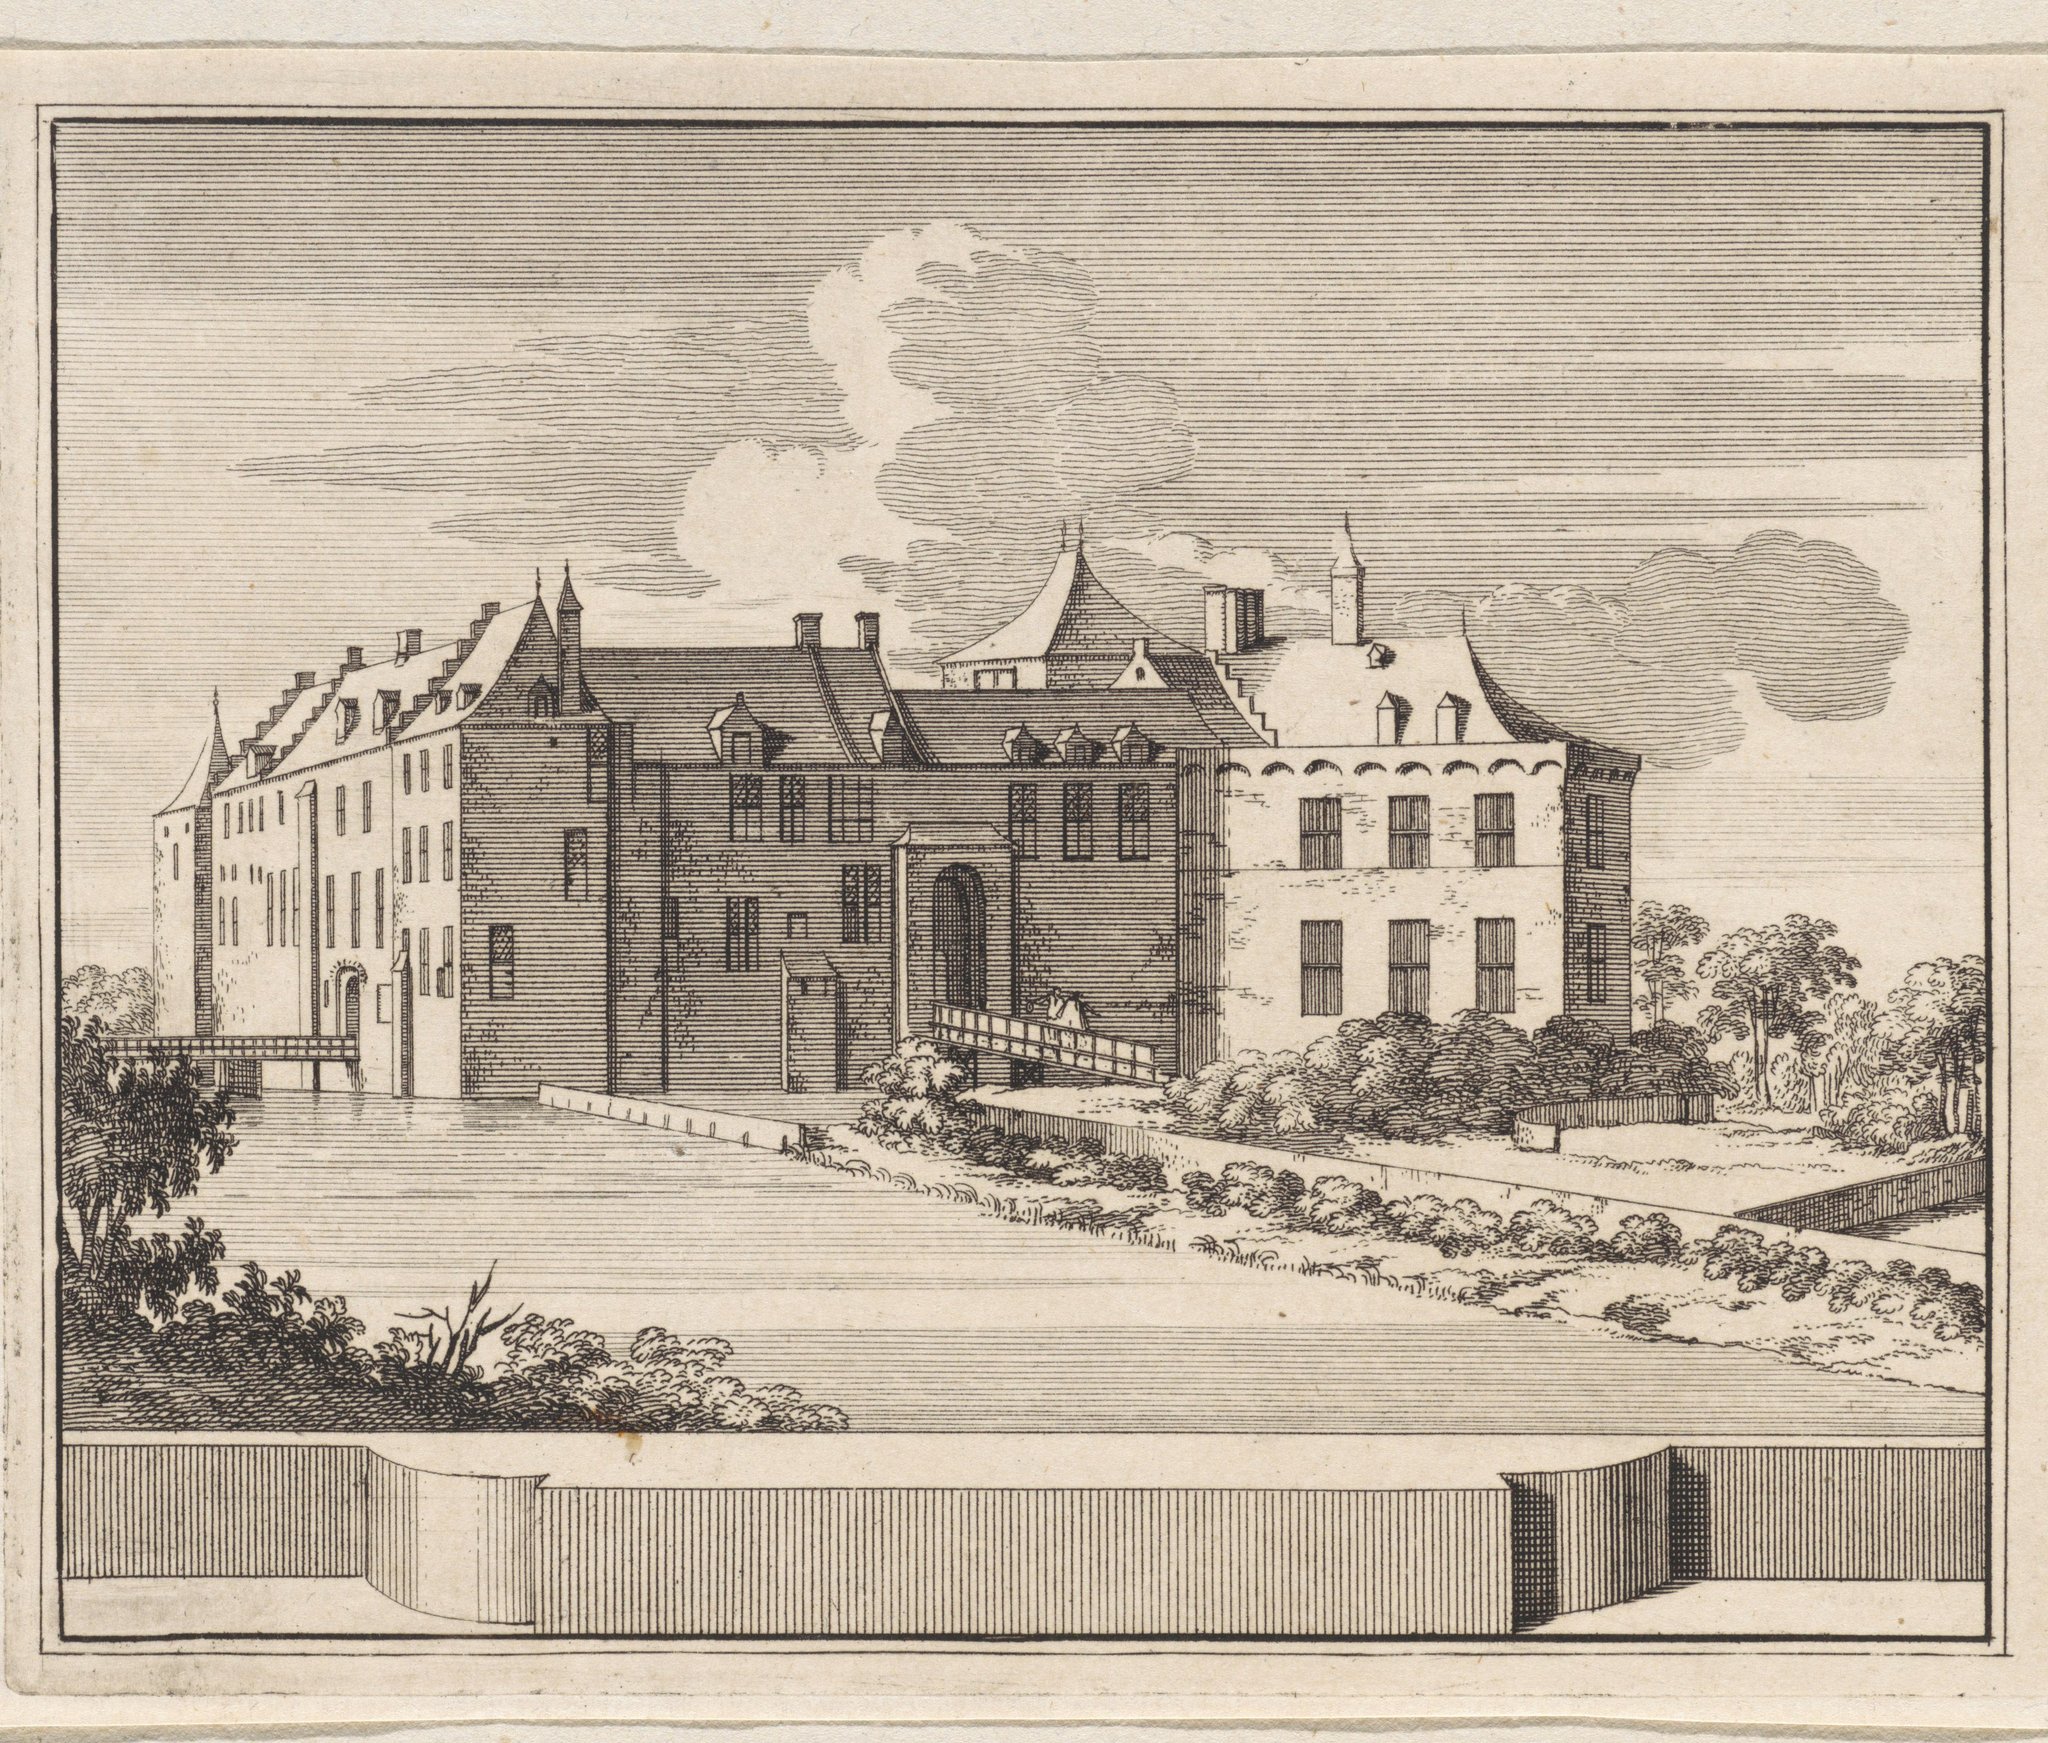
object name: print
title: Gezicht op kasteel IJsselstein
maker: jacobus schijnvoet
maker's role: draughtsman, print maker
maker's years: 1685-1743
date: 1711-1774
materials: paper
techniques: etching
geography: amsterdam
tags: castle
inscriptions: collector's mark: Lugt 2228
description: Latere staat van deze prent als illustratie opgenomen in: Smids, Ludolph. Schatkamer der Nederlandsse[!] oudheden; of Woordenboek, behelsende Nederlands steden, Amsterdam: Pieter de Coup, 1711. Verscheen tevens in de heruitgave van voorgenoemd werk in 1737 en 1774. In 1721 verscheen er een uitgave met alleen de prenten: Nederlandsche oudheden, bestaande in zestig verbeeldingen (...) gelegen in Holland, 't Sticht van Utrecht en Gelderland enz. Amsterdam: Hendrik Bosch, 1721.